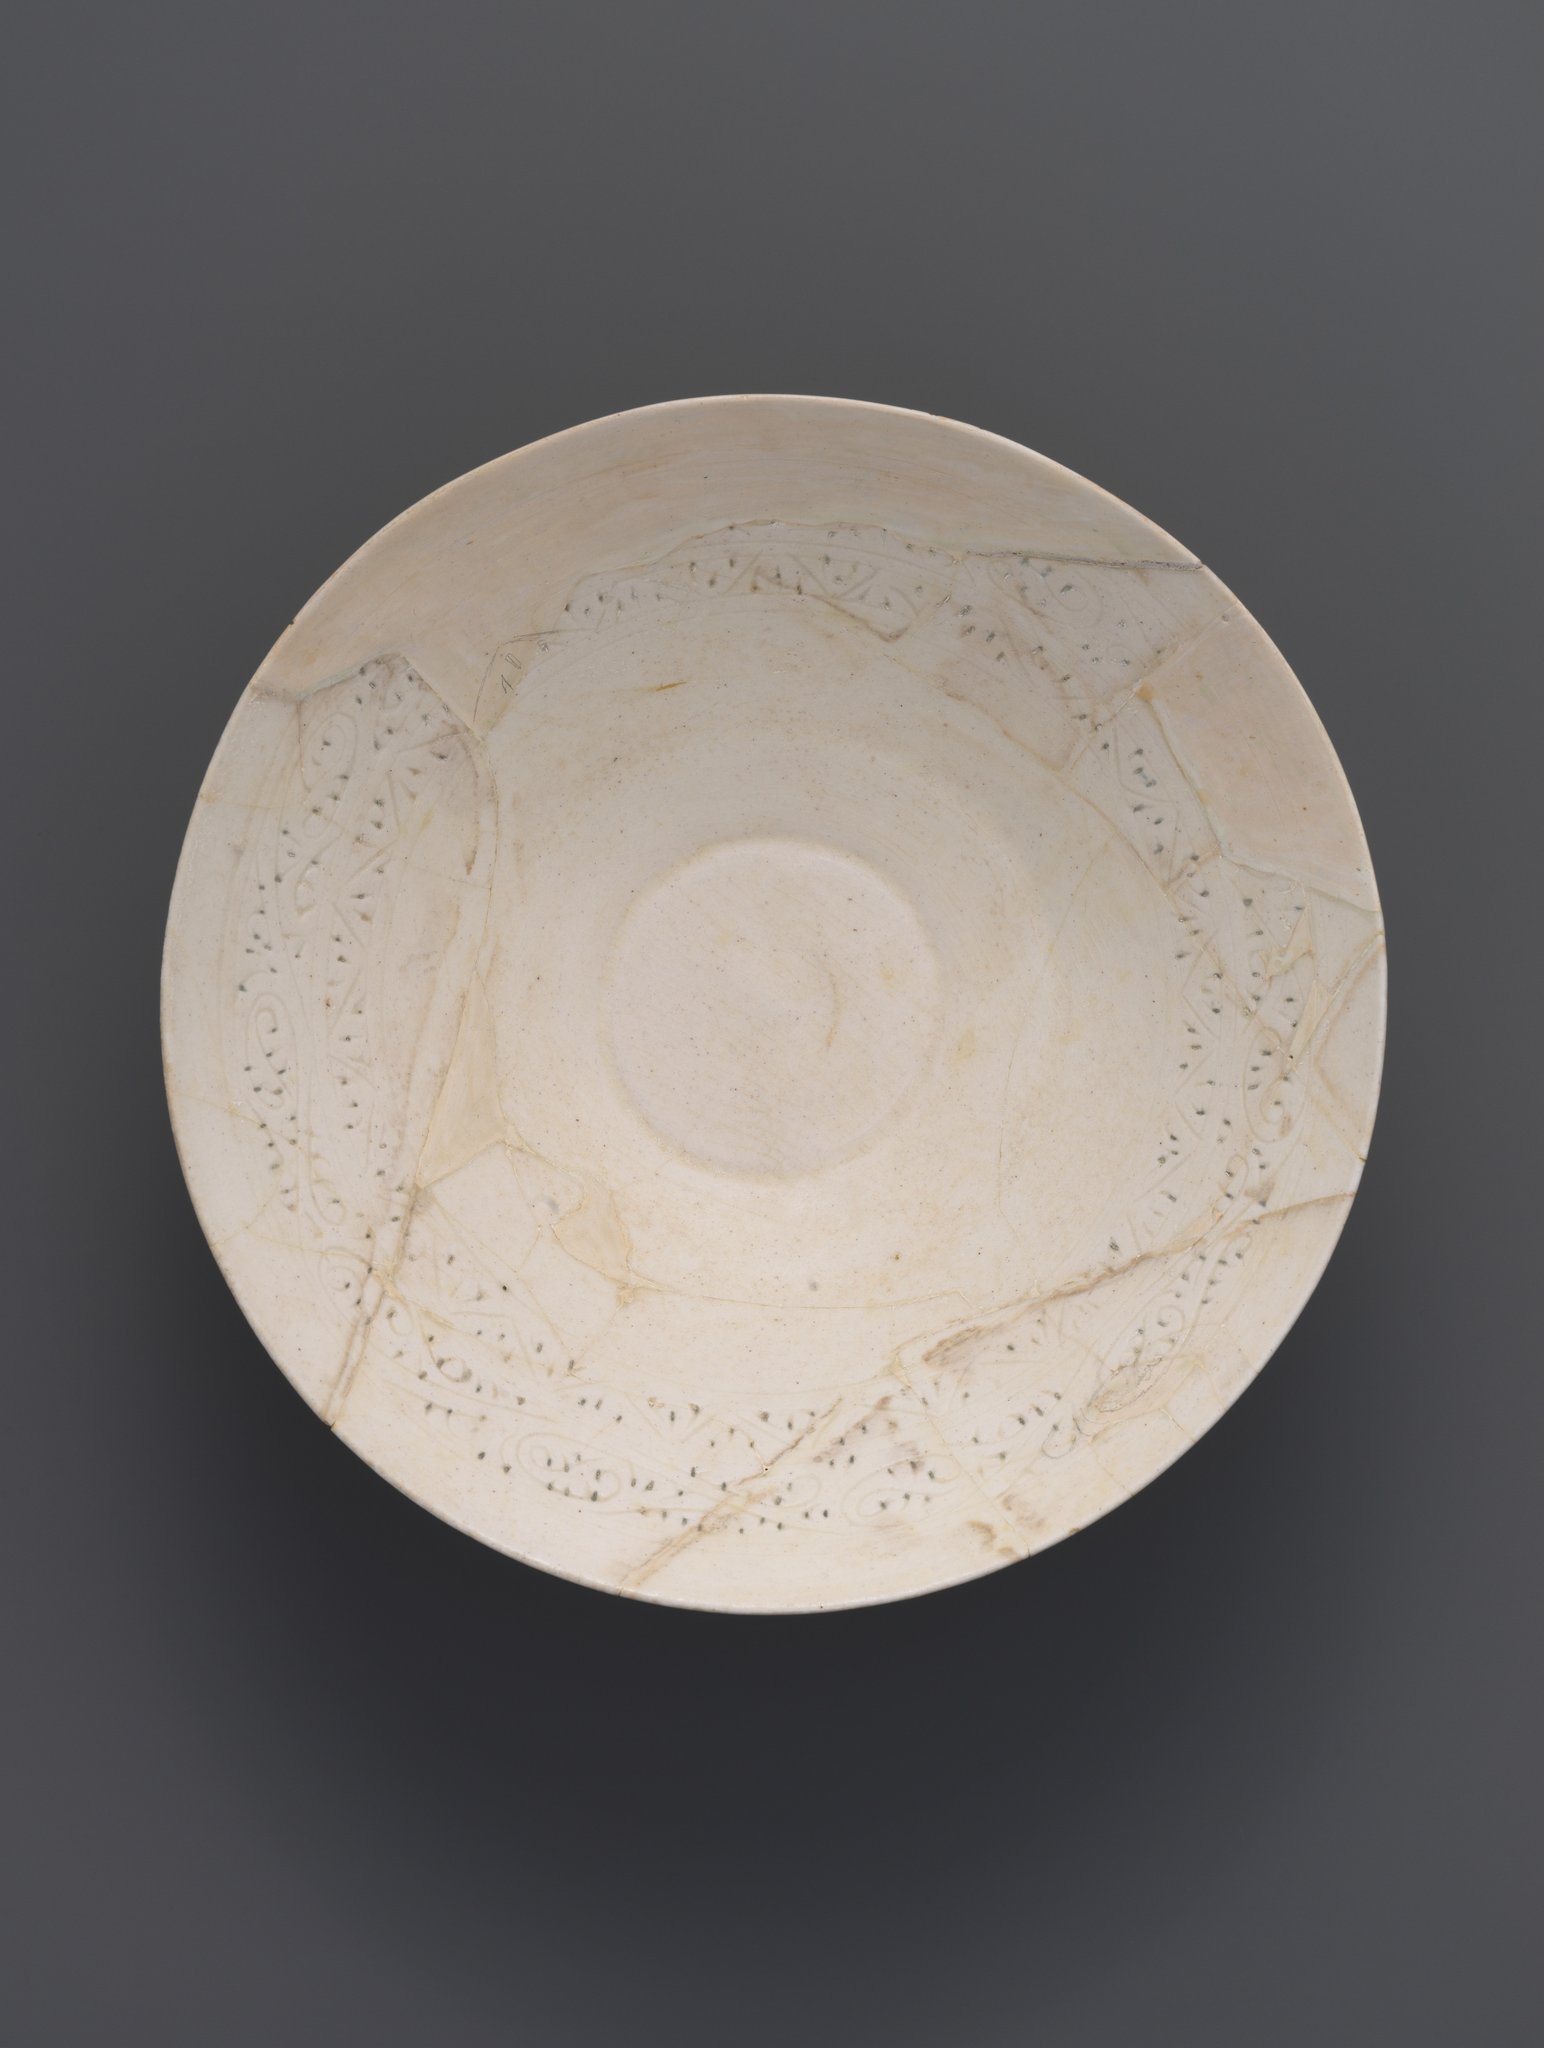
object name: bowl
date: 1101-1200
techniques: incising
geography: iran